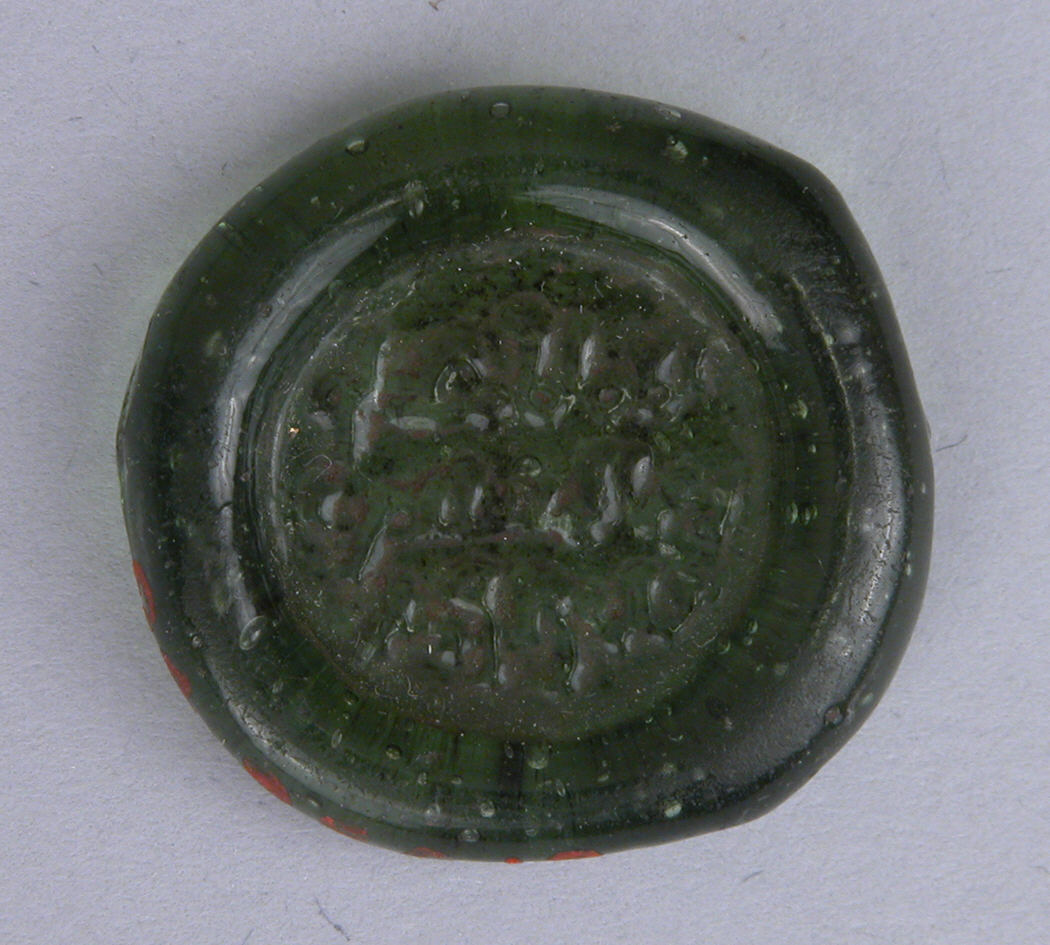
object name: coin weight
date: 1001-1100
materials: glass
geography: egypt